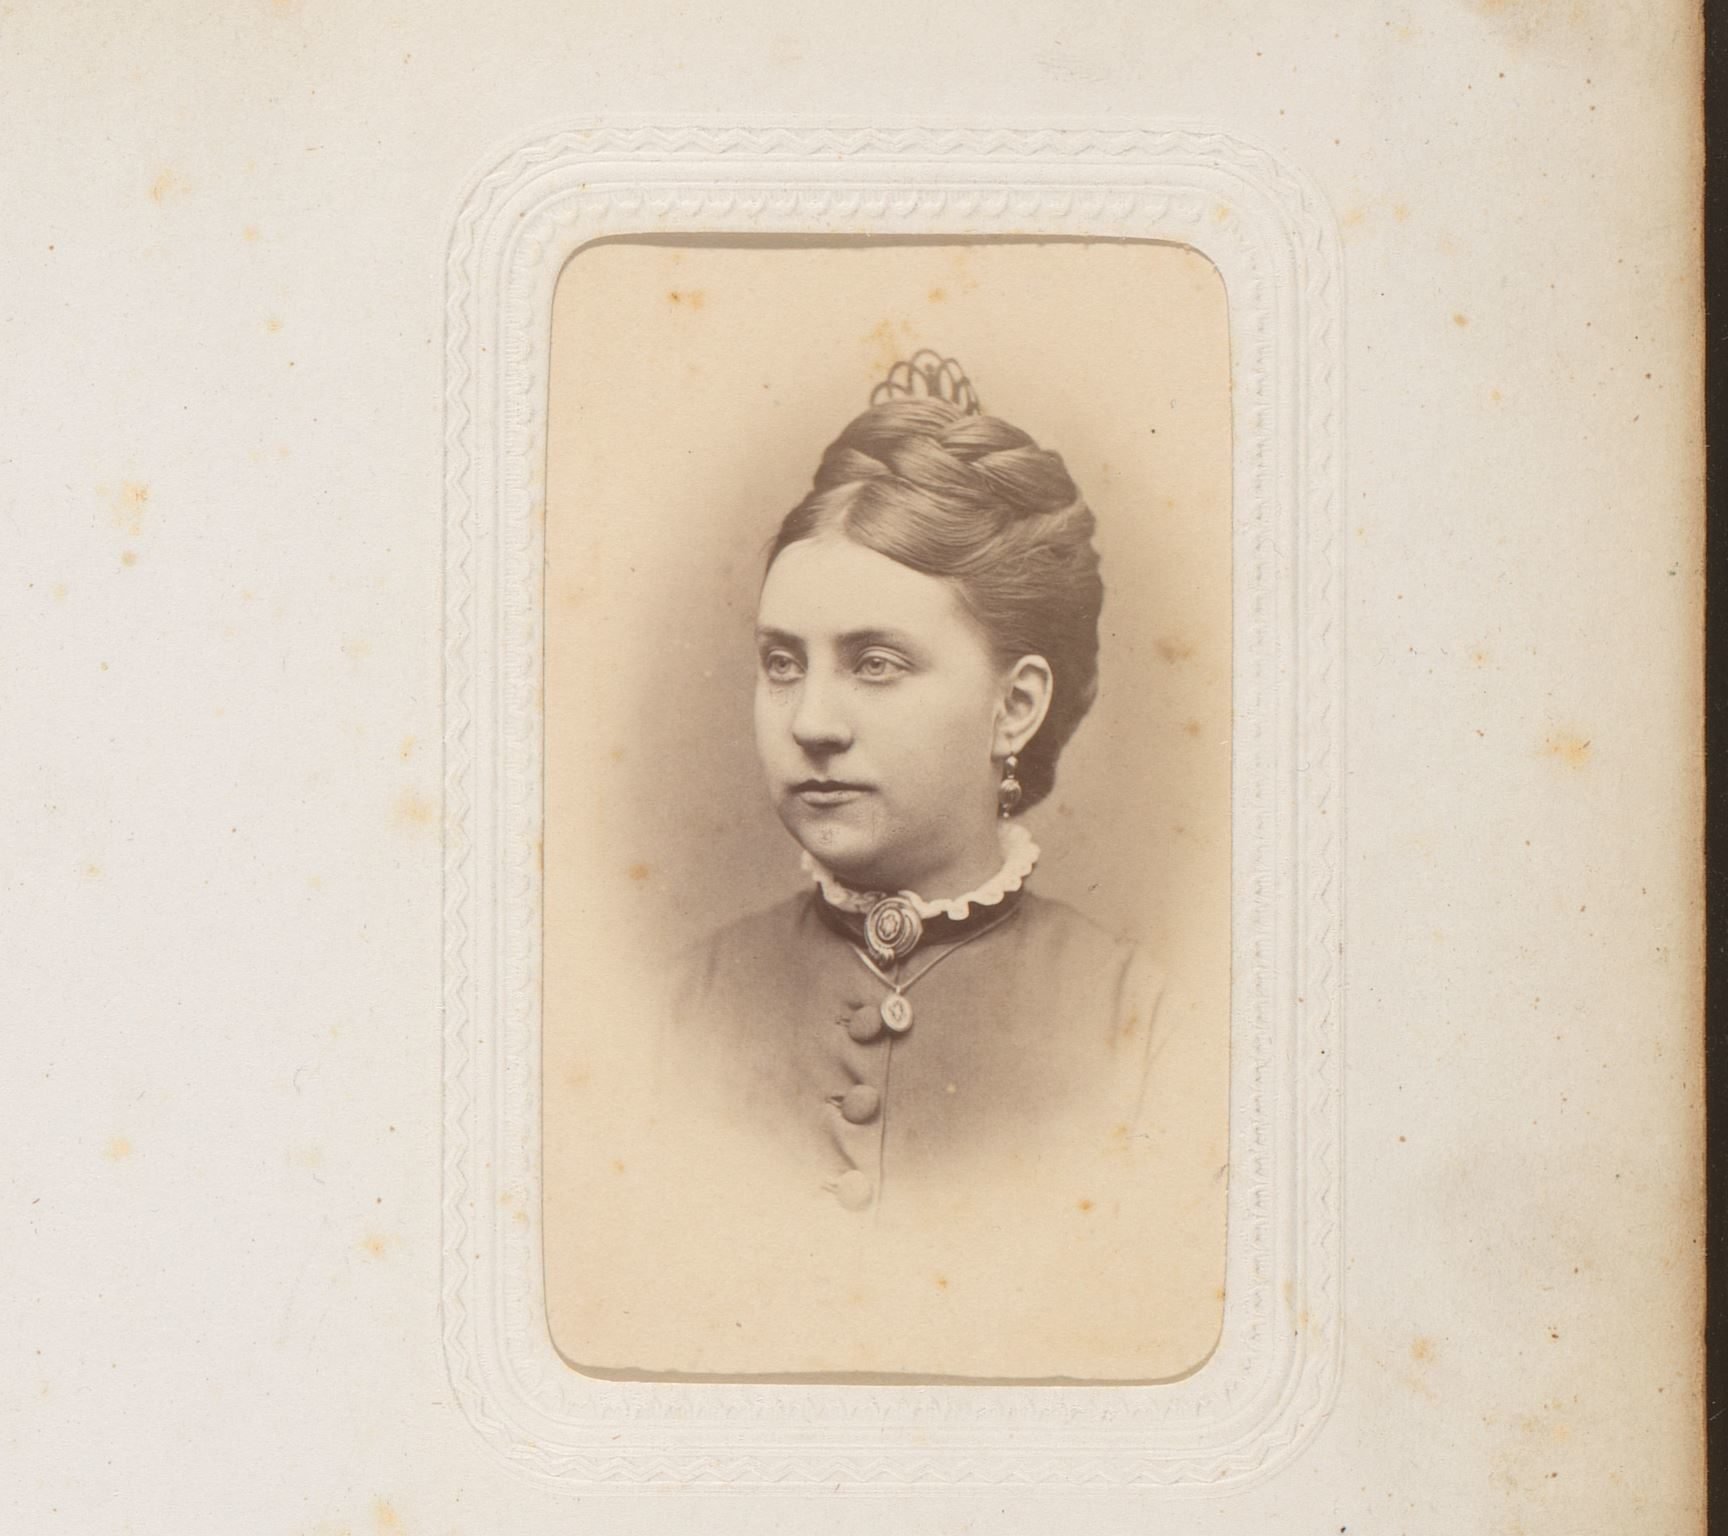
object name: carte de visite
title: Portret van een jonge vrouw met halsketting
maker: ernst wolffram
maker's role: fotograaf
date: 1850-1900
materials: cardboard, photographic support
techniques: albumen print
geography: bremen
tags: adolescent, young woman, maiden, historical persons - bb - woman, necklace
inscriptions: inscription: ‘No. 7904/ der Originalplatte./ E Wolffram/ BREMEN/ Fedelhören 14/ PARTERRE.’